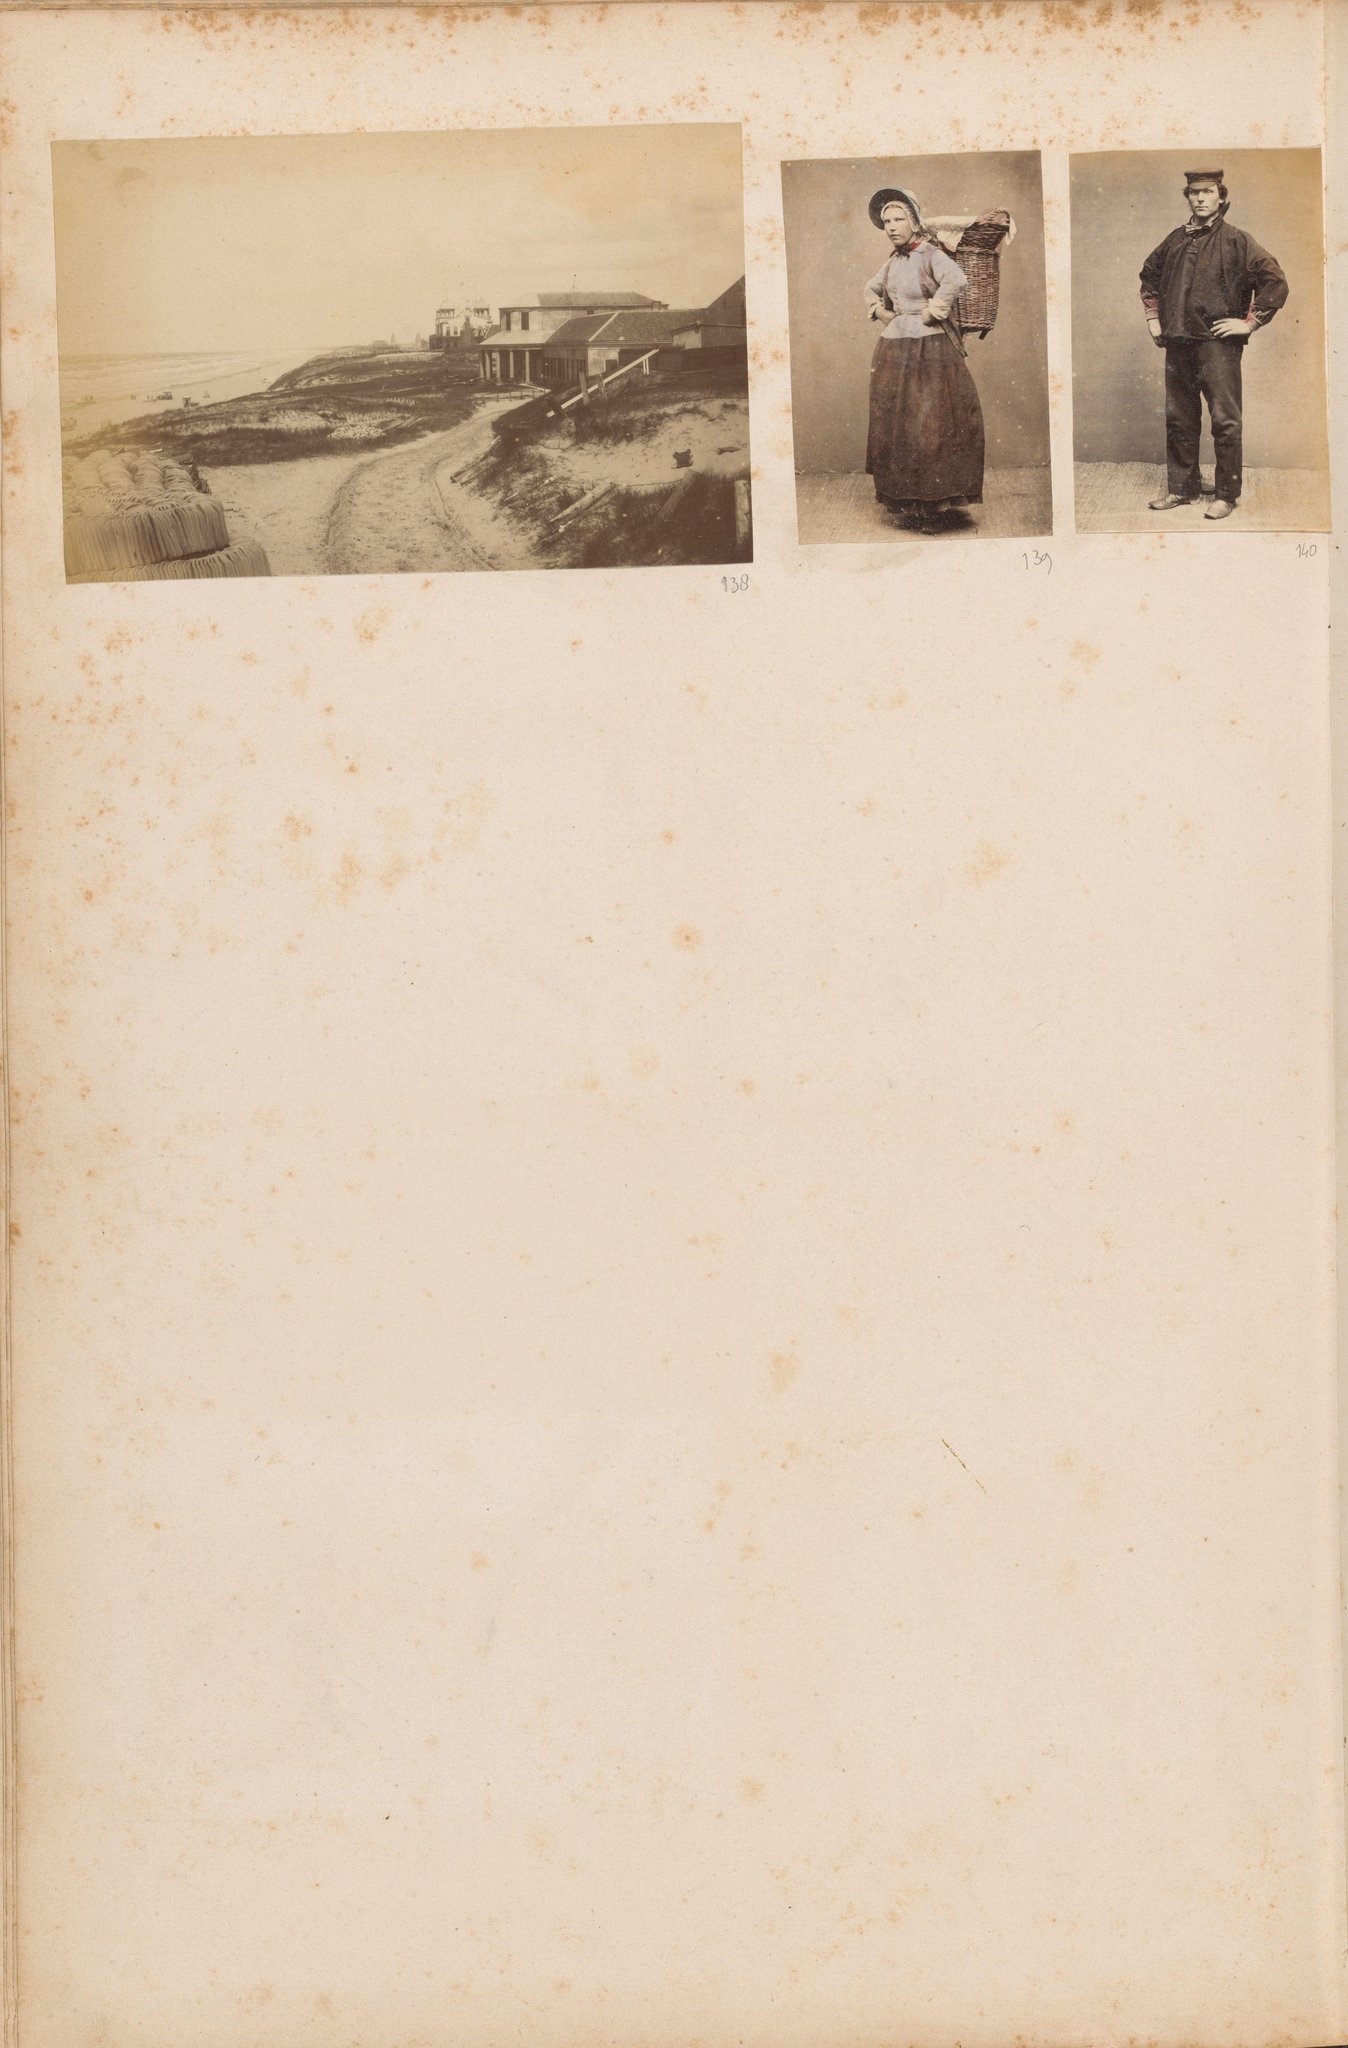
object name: photograph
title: Portret van een man in (mogelijk) Zandvoortse klederdracht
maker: Anonymous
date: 1870-1880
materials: paper, photographic support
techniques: albumen print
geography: netherlands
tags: folk costume, regional costume, fisherman, netherlands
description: Onderdeel van Fotoalbum van Robert Daniel Crommelin (1841-1907).